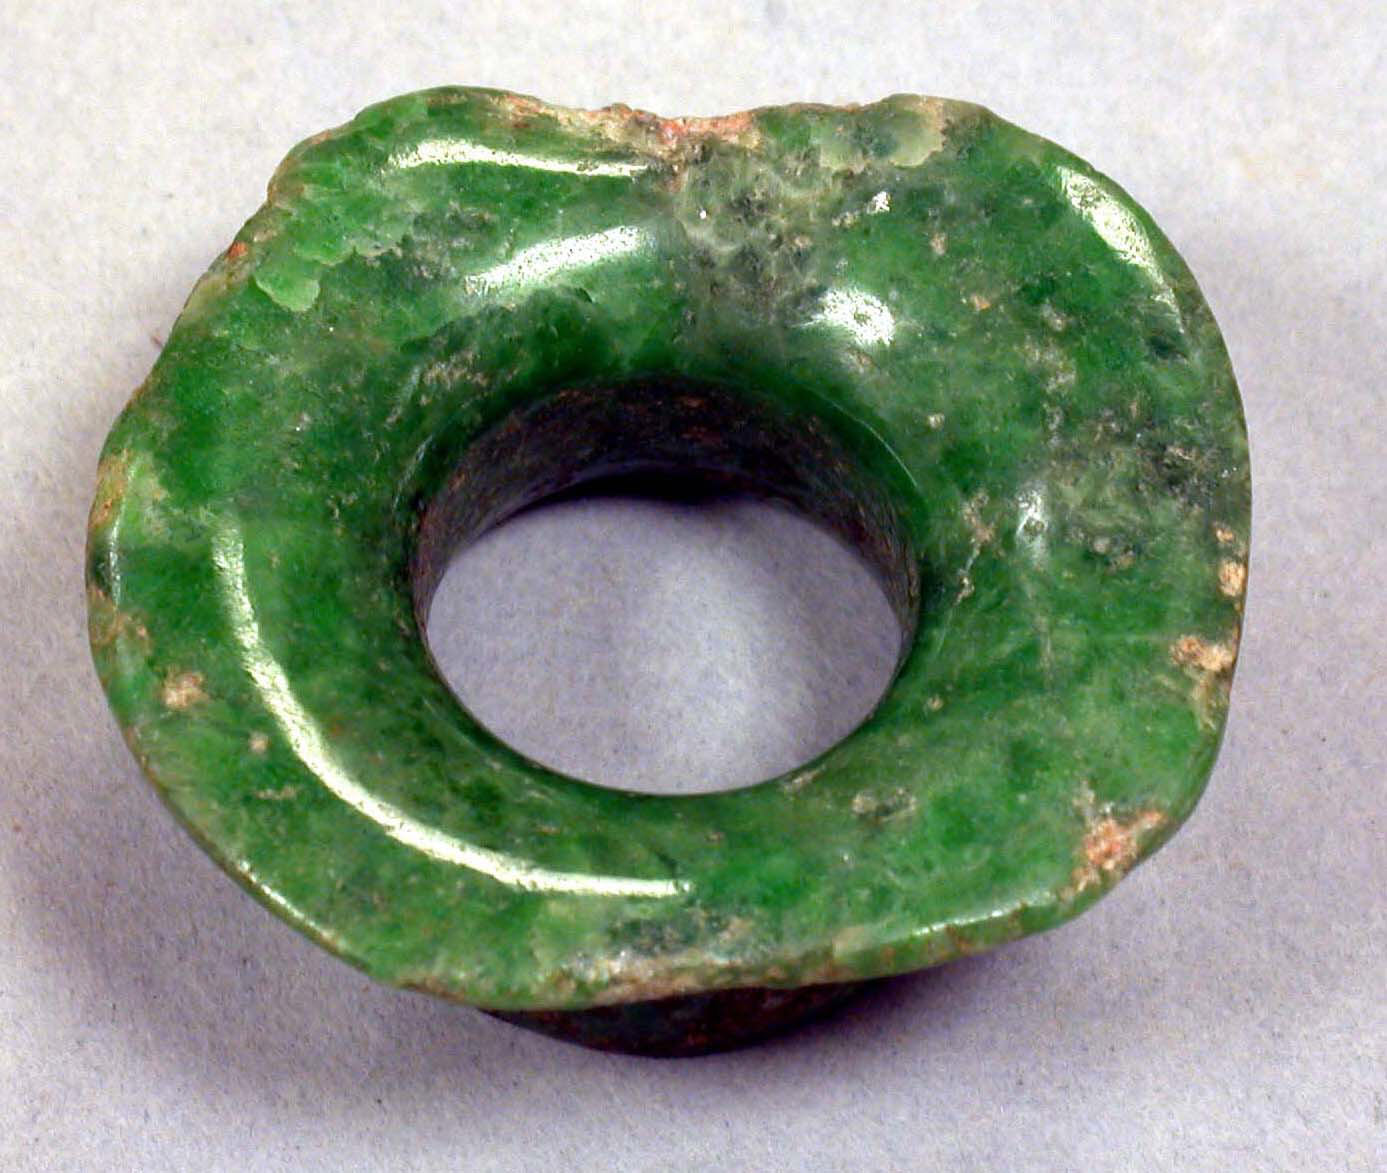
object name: earflare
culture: maya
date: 201-900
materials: jade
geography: el salvador